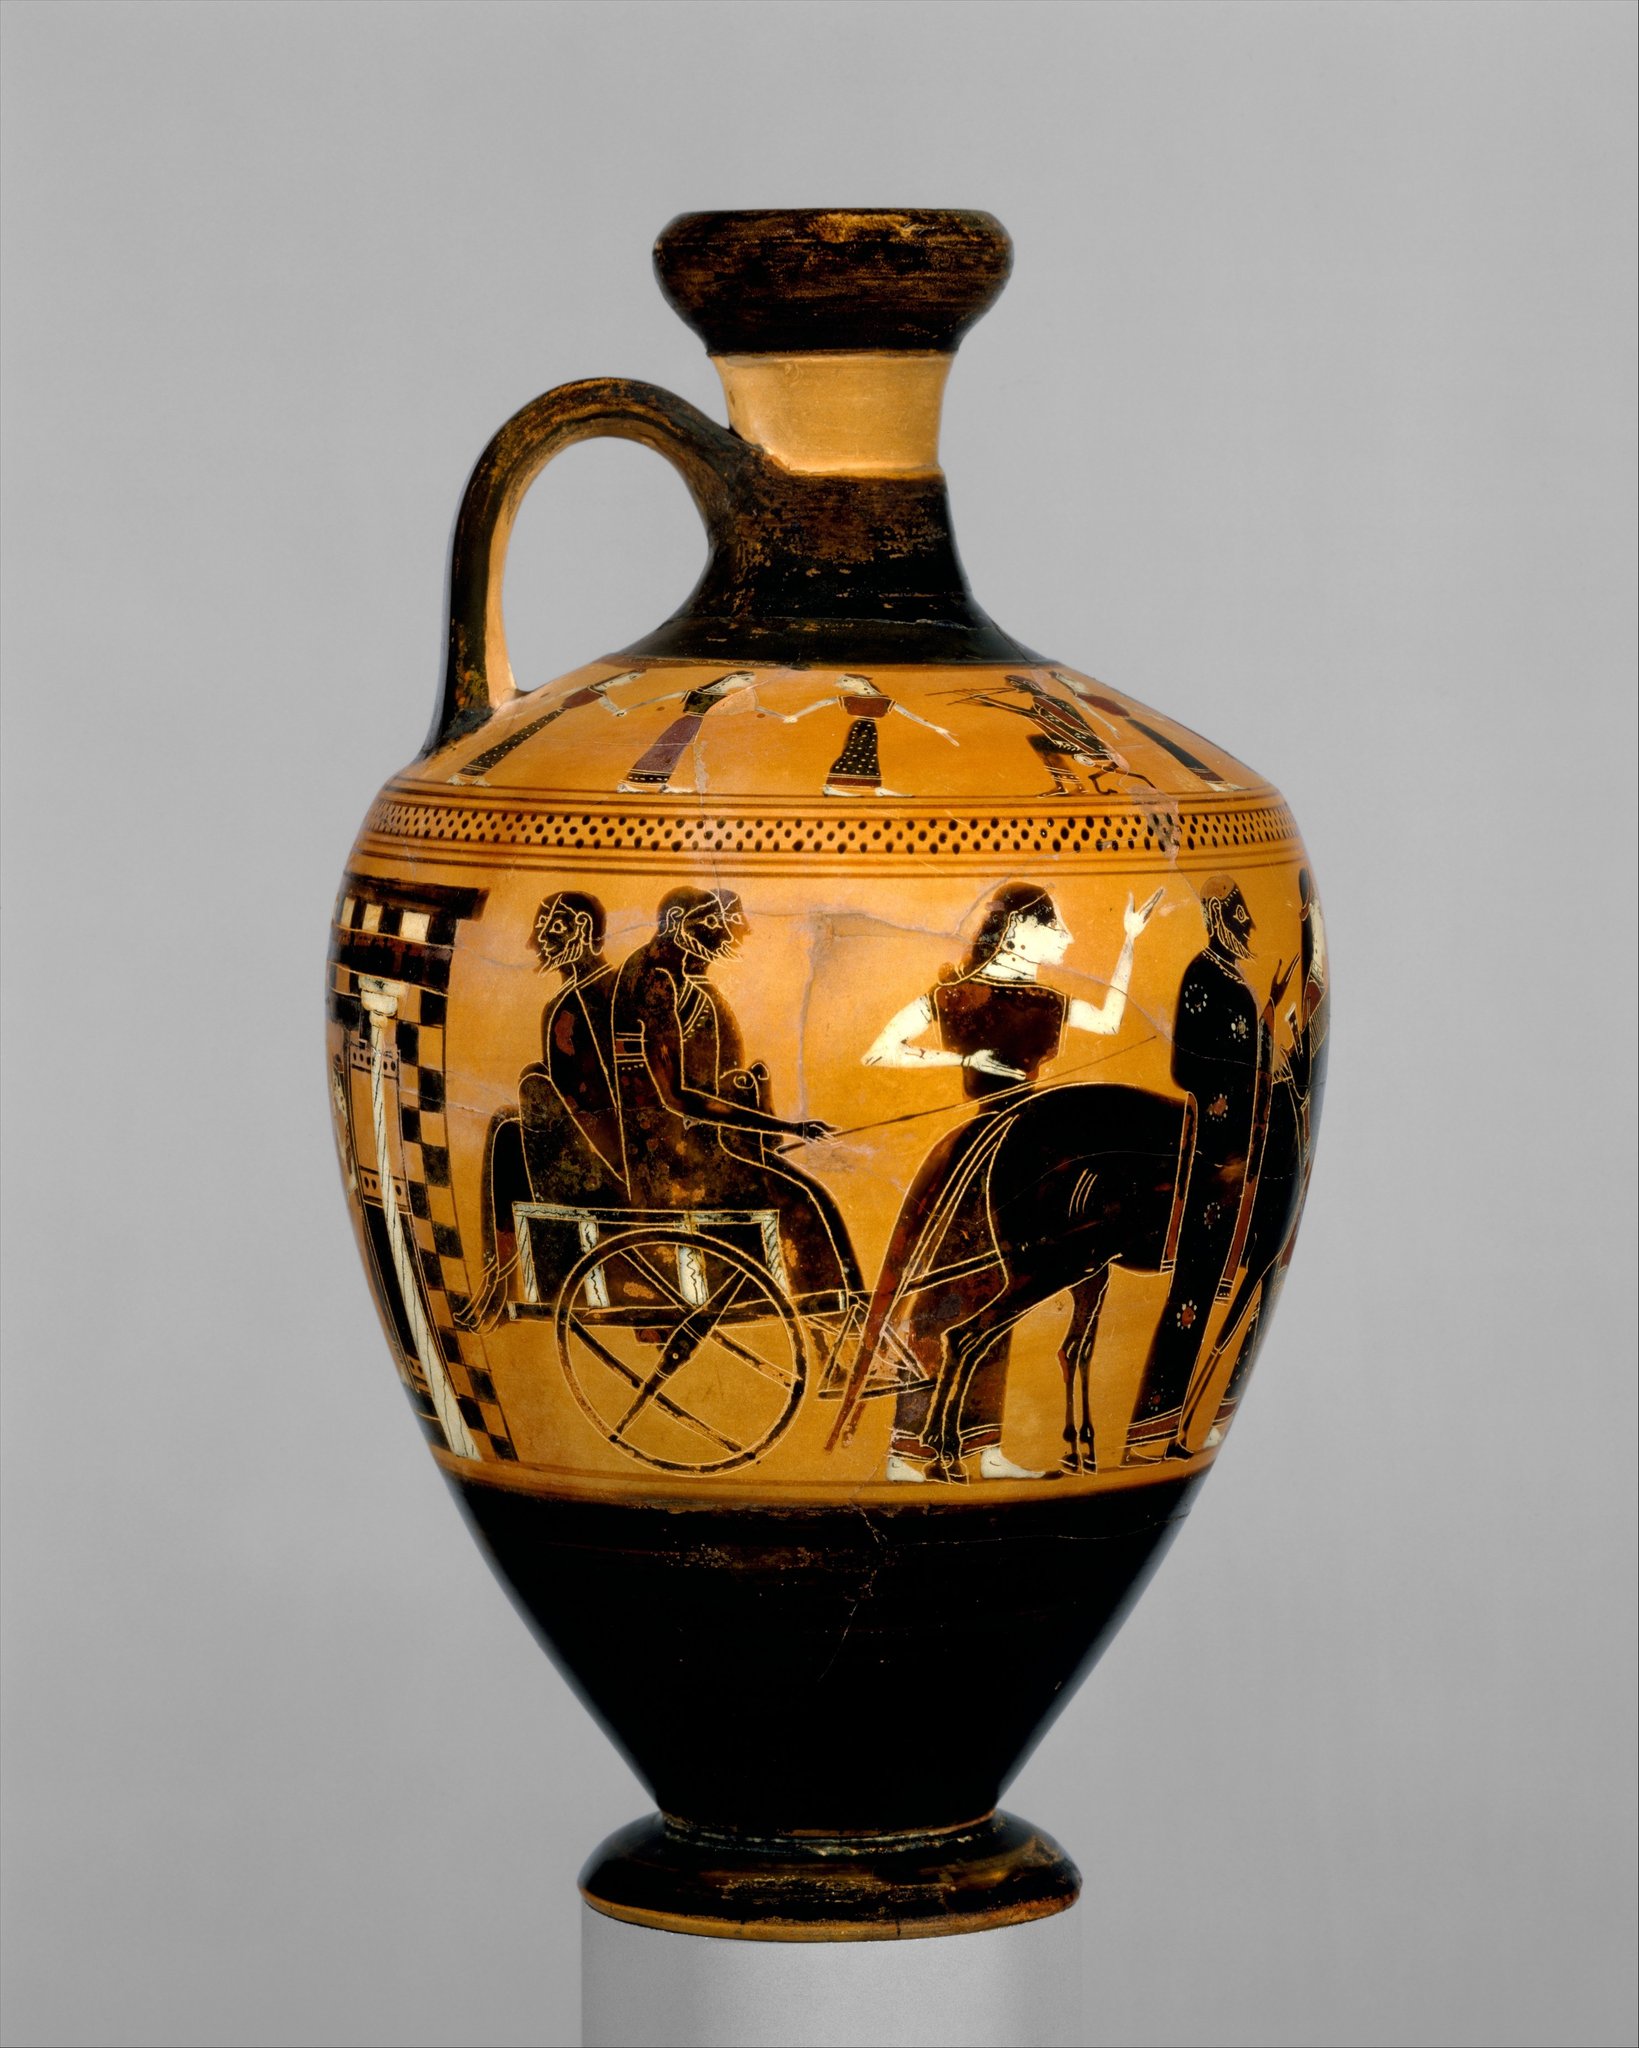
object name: lekythos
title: Terracotta lekythos (oil flask)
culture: greek, attic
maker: amasis painter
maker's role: artist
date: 550-530 BCE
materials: terracotta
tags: men,women,donkeys,musicians,carts